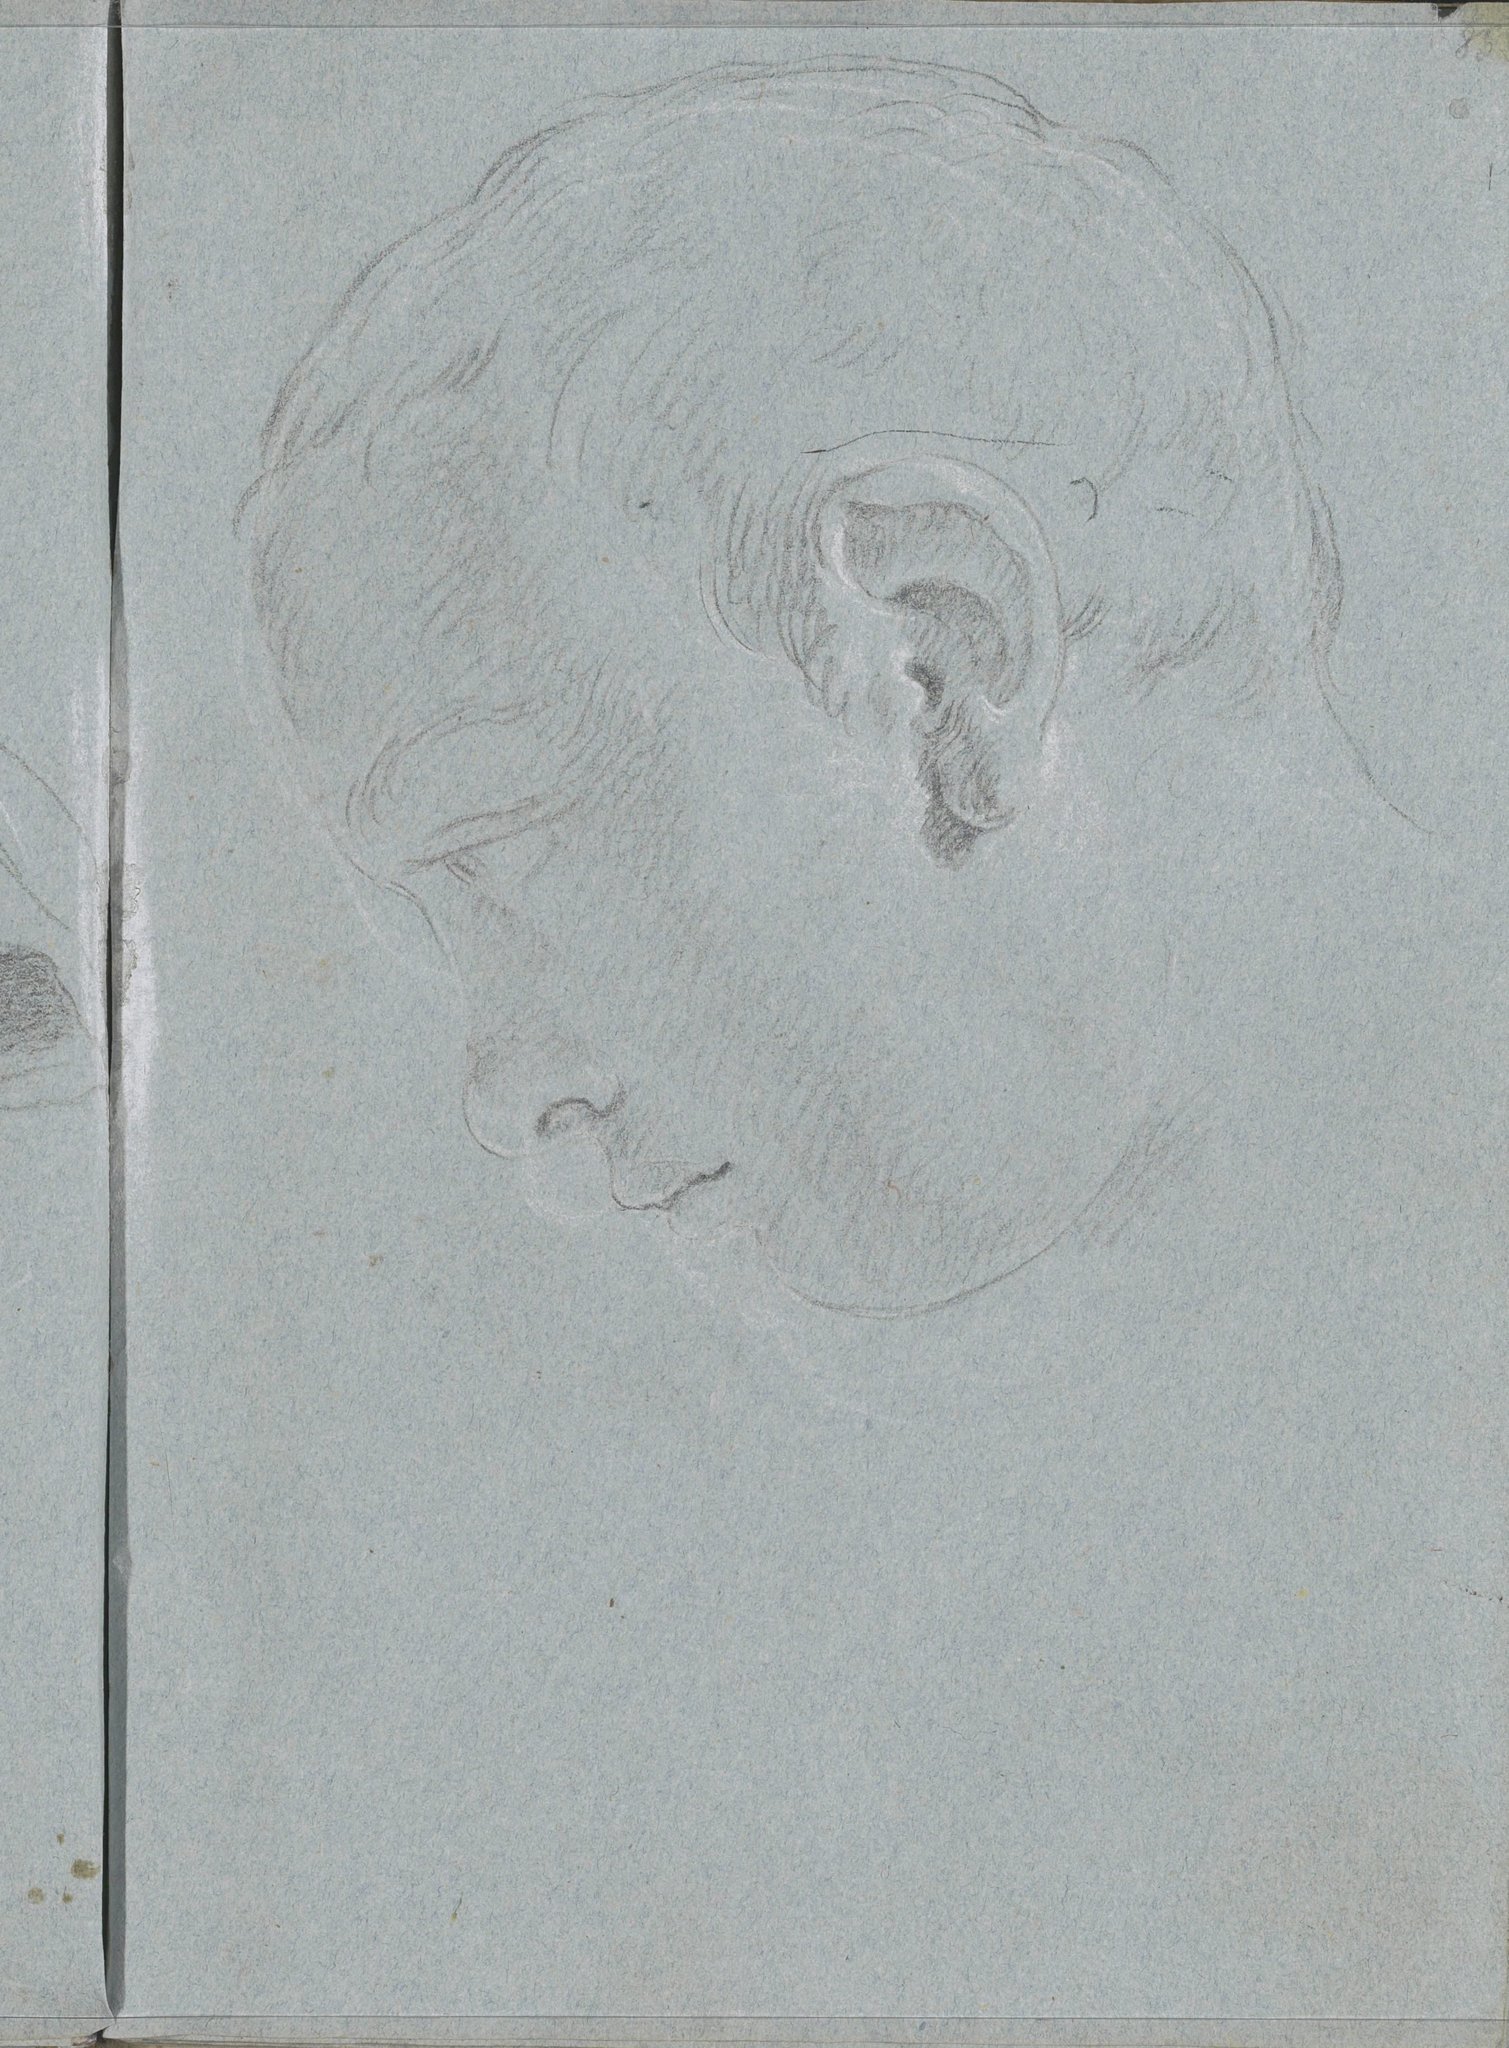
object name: sketchbook leaf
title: Kop van een jongen of jongeman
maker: lorenzo baldissera tiepolo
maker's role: draughtsman, print maker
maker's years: 1736-1776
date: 1751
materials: chalk, paper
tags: head (human)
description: Bladzijde 85 uit een schetsboek met 158 bladzijden.